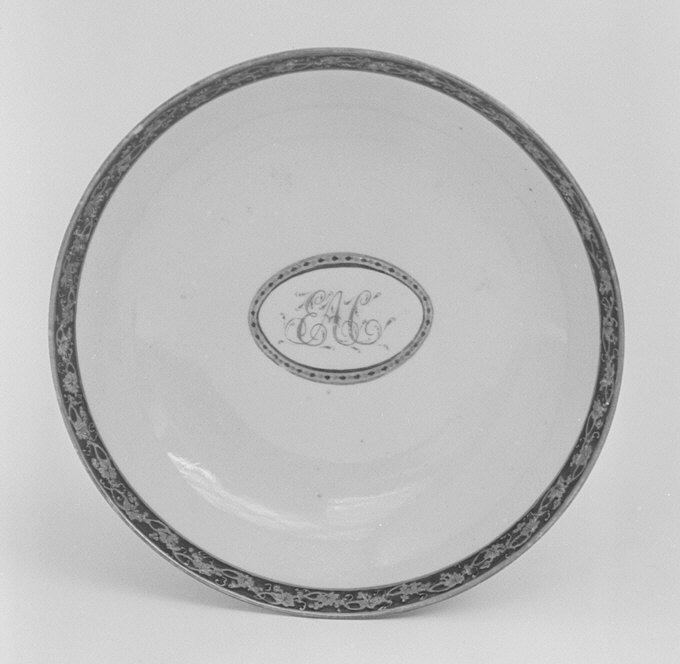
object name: saucer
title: Saucer (part of a service)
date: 1790-1800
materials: hard paste porcelain